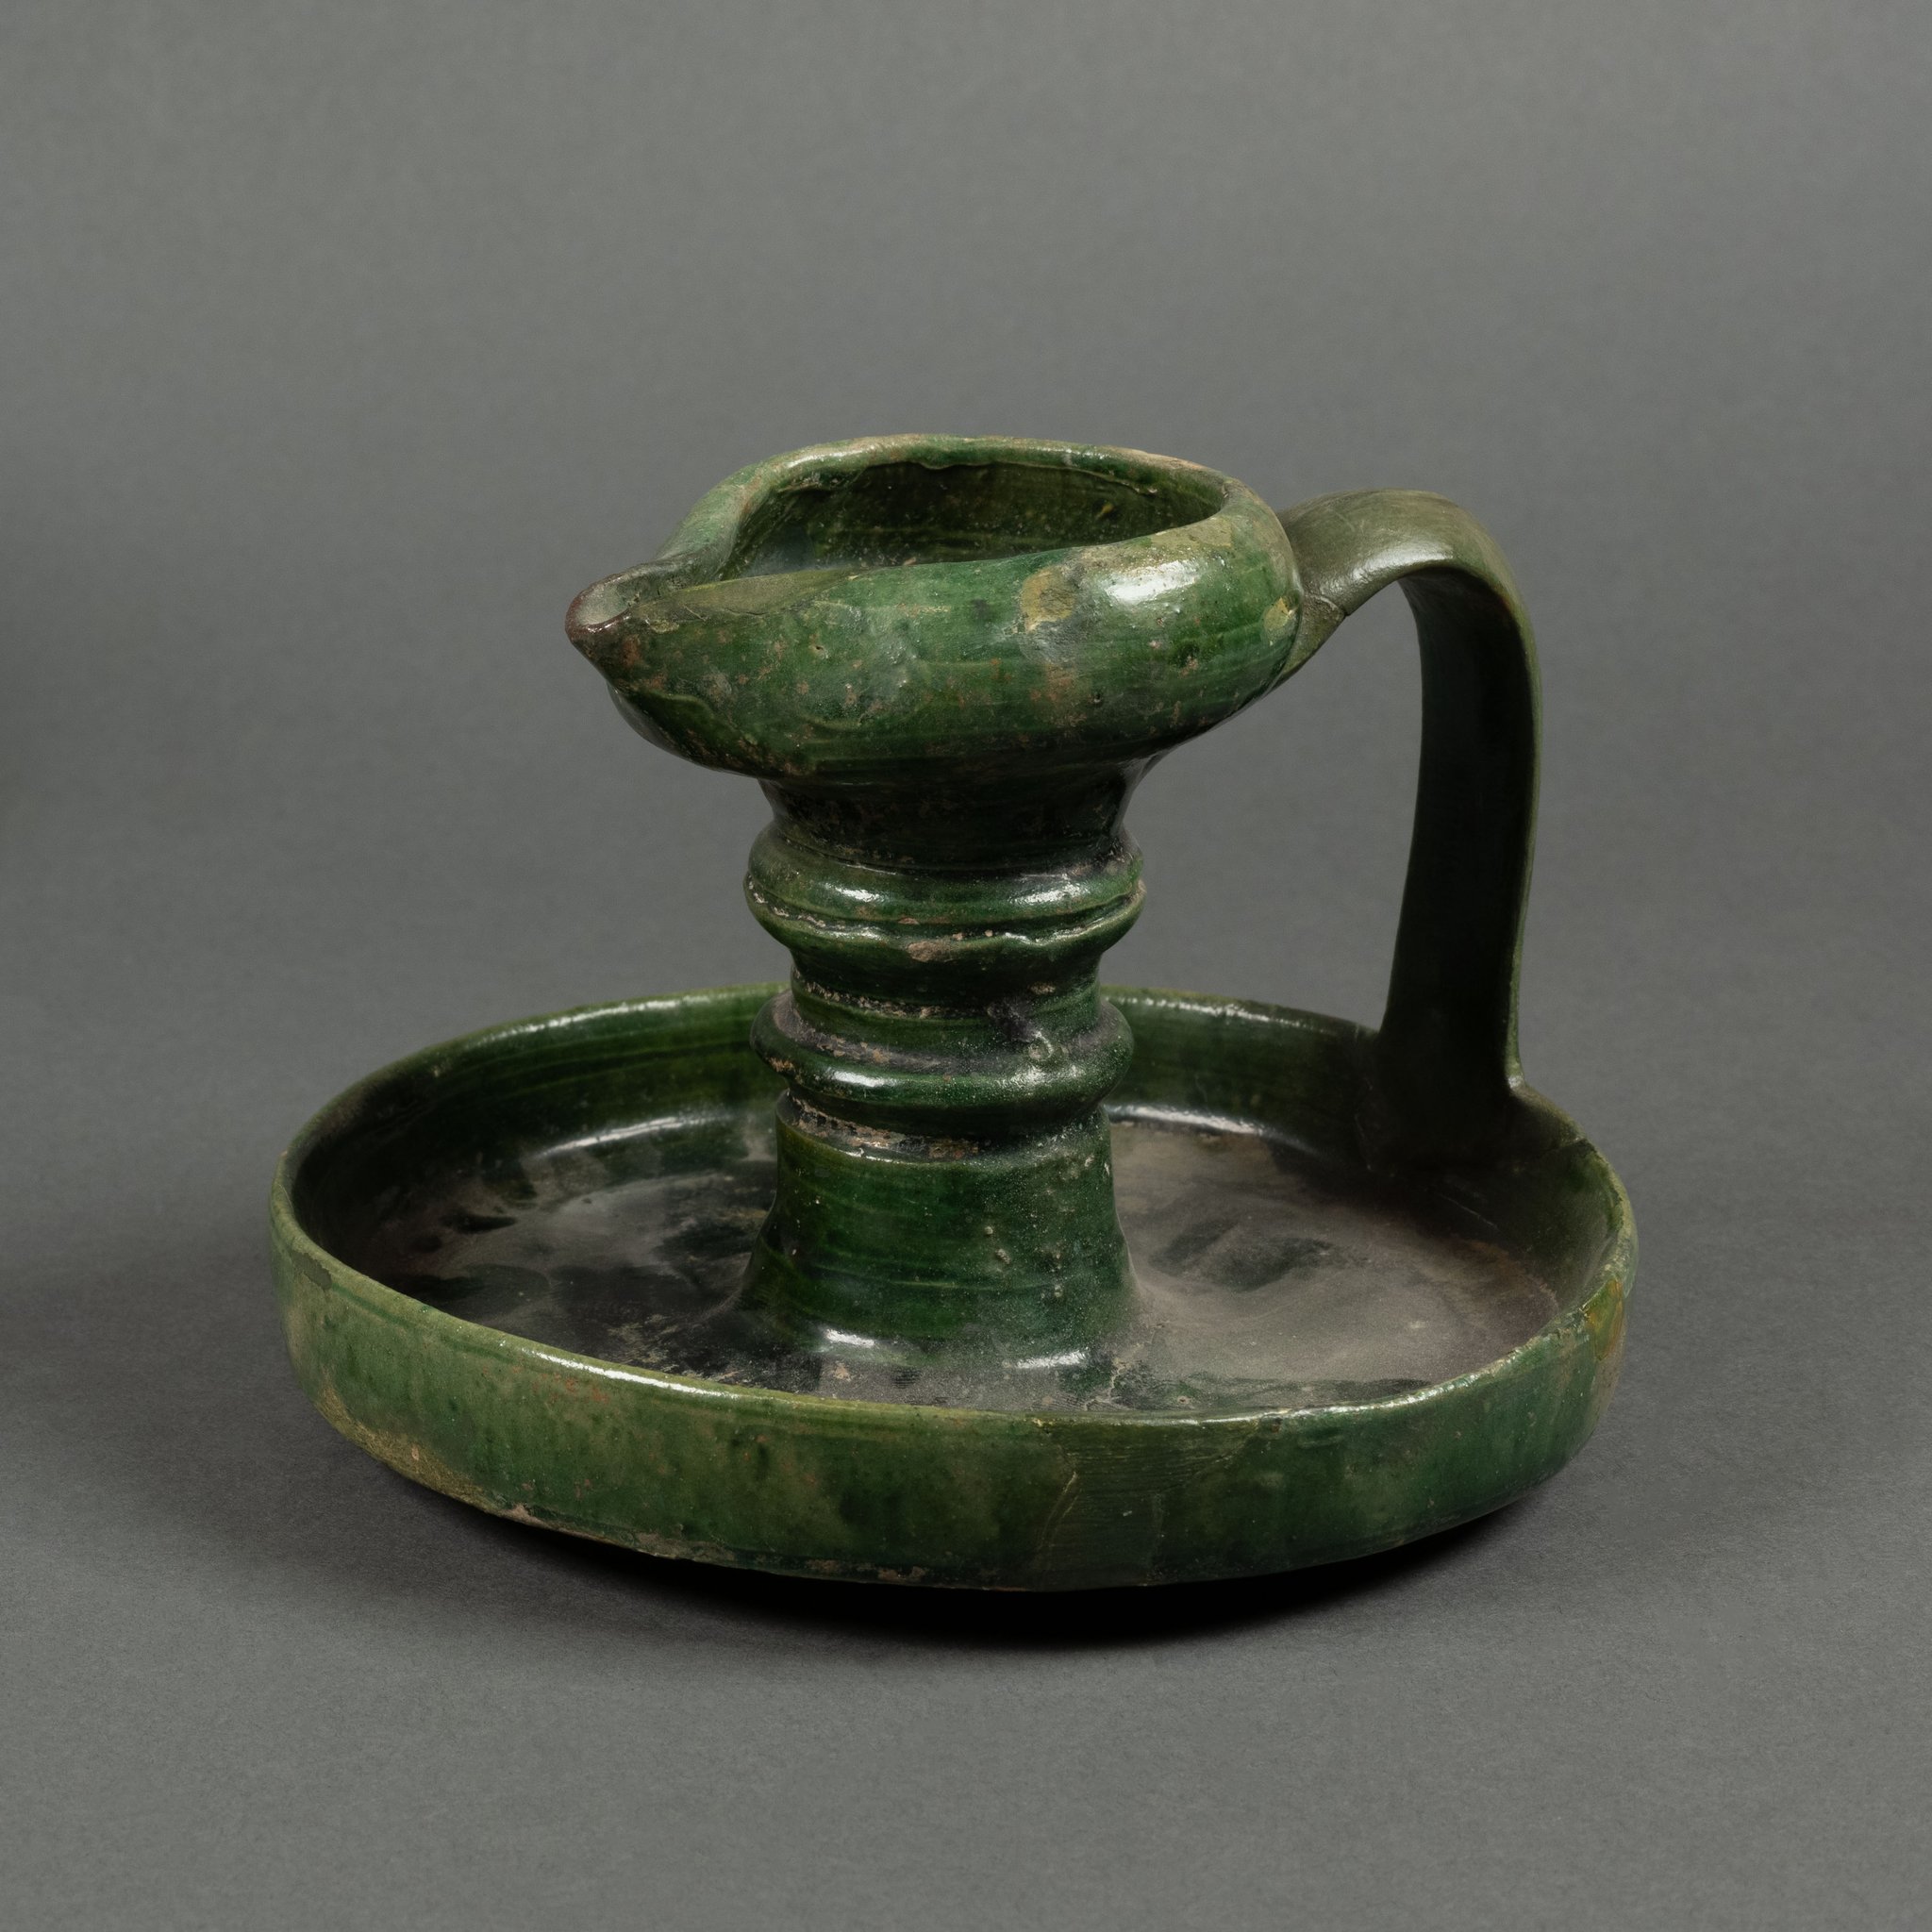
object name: lamp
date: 801-1000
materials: earthenware, glaze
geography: iran